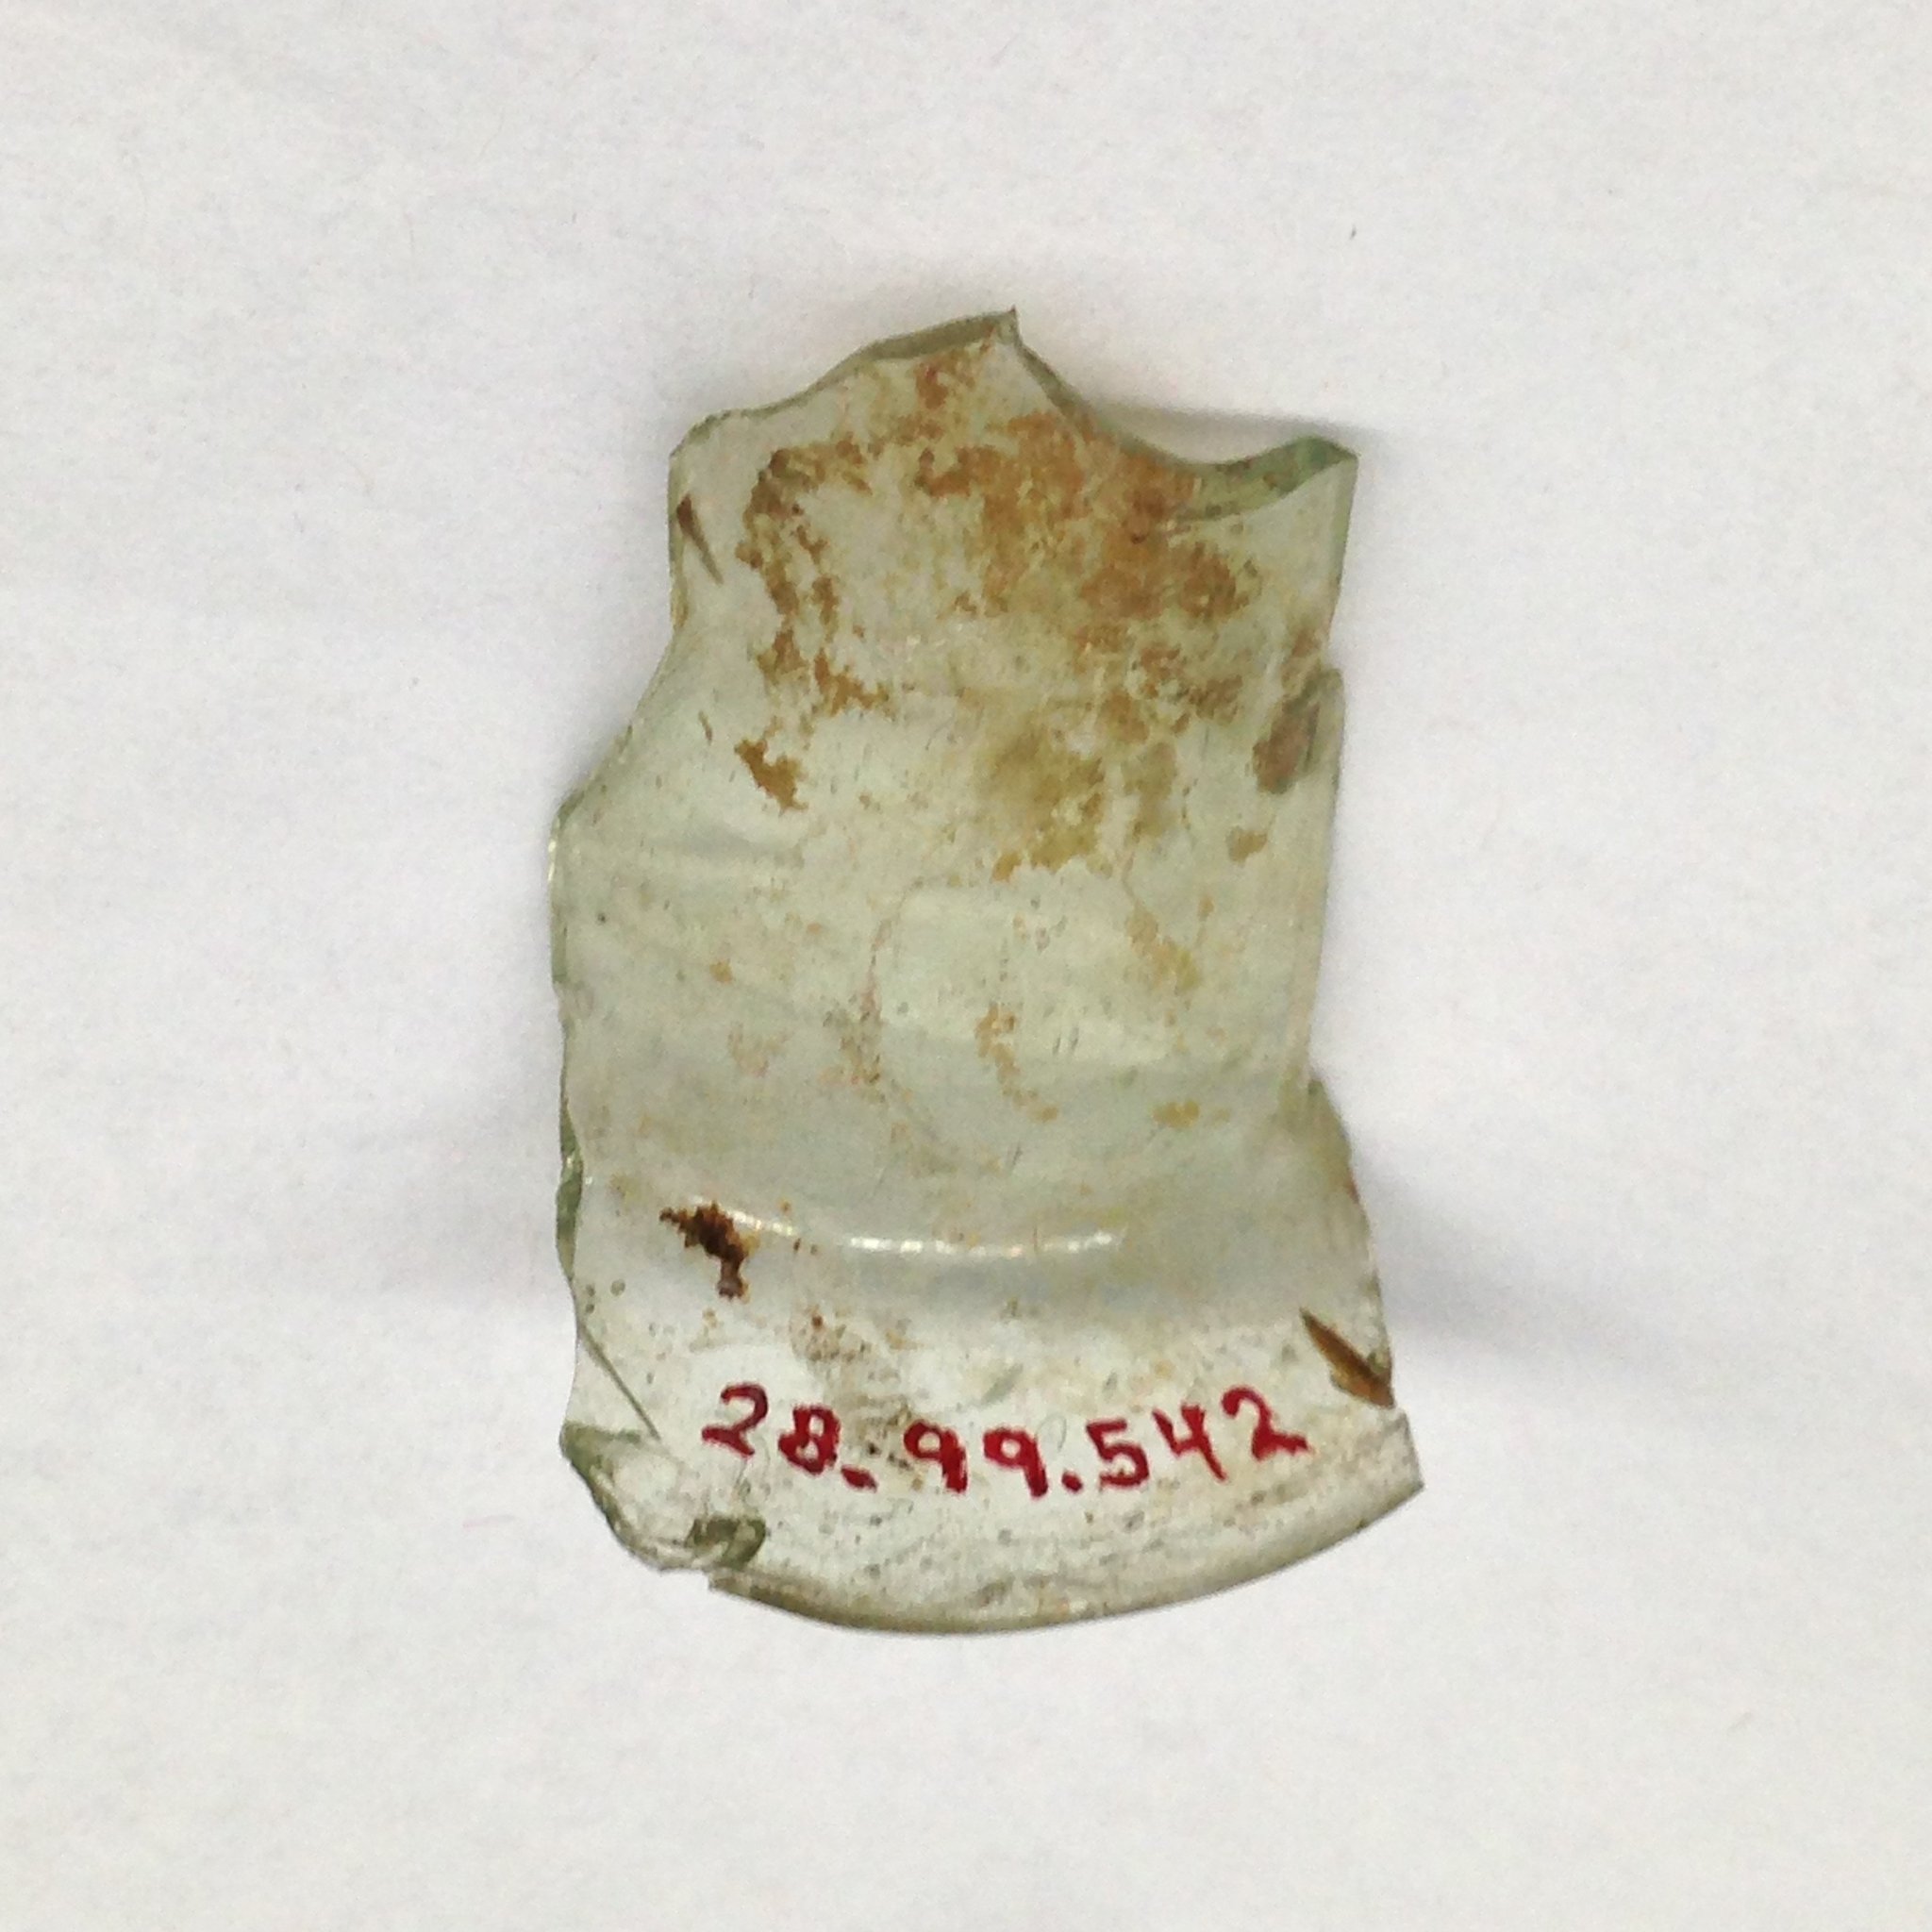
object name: fragment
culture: european or middle eastern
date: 1150-1250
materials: ceramic, glass